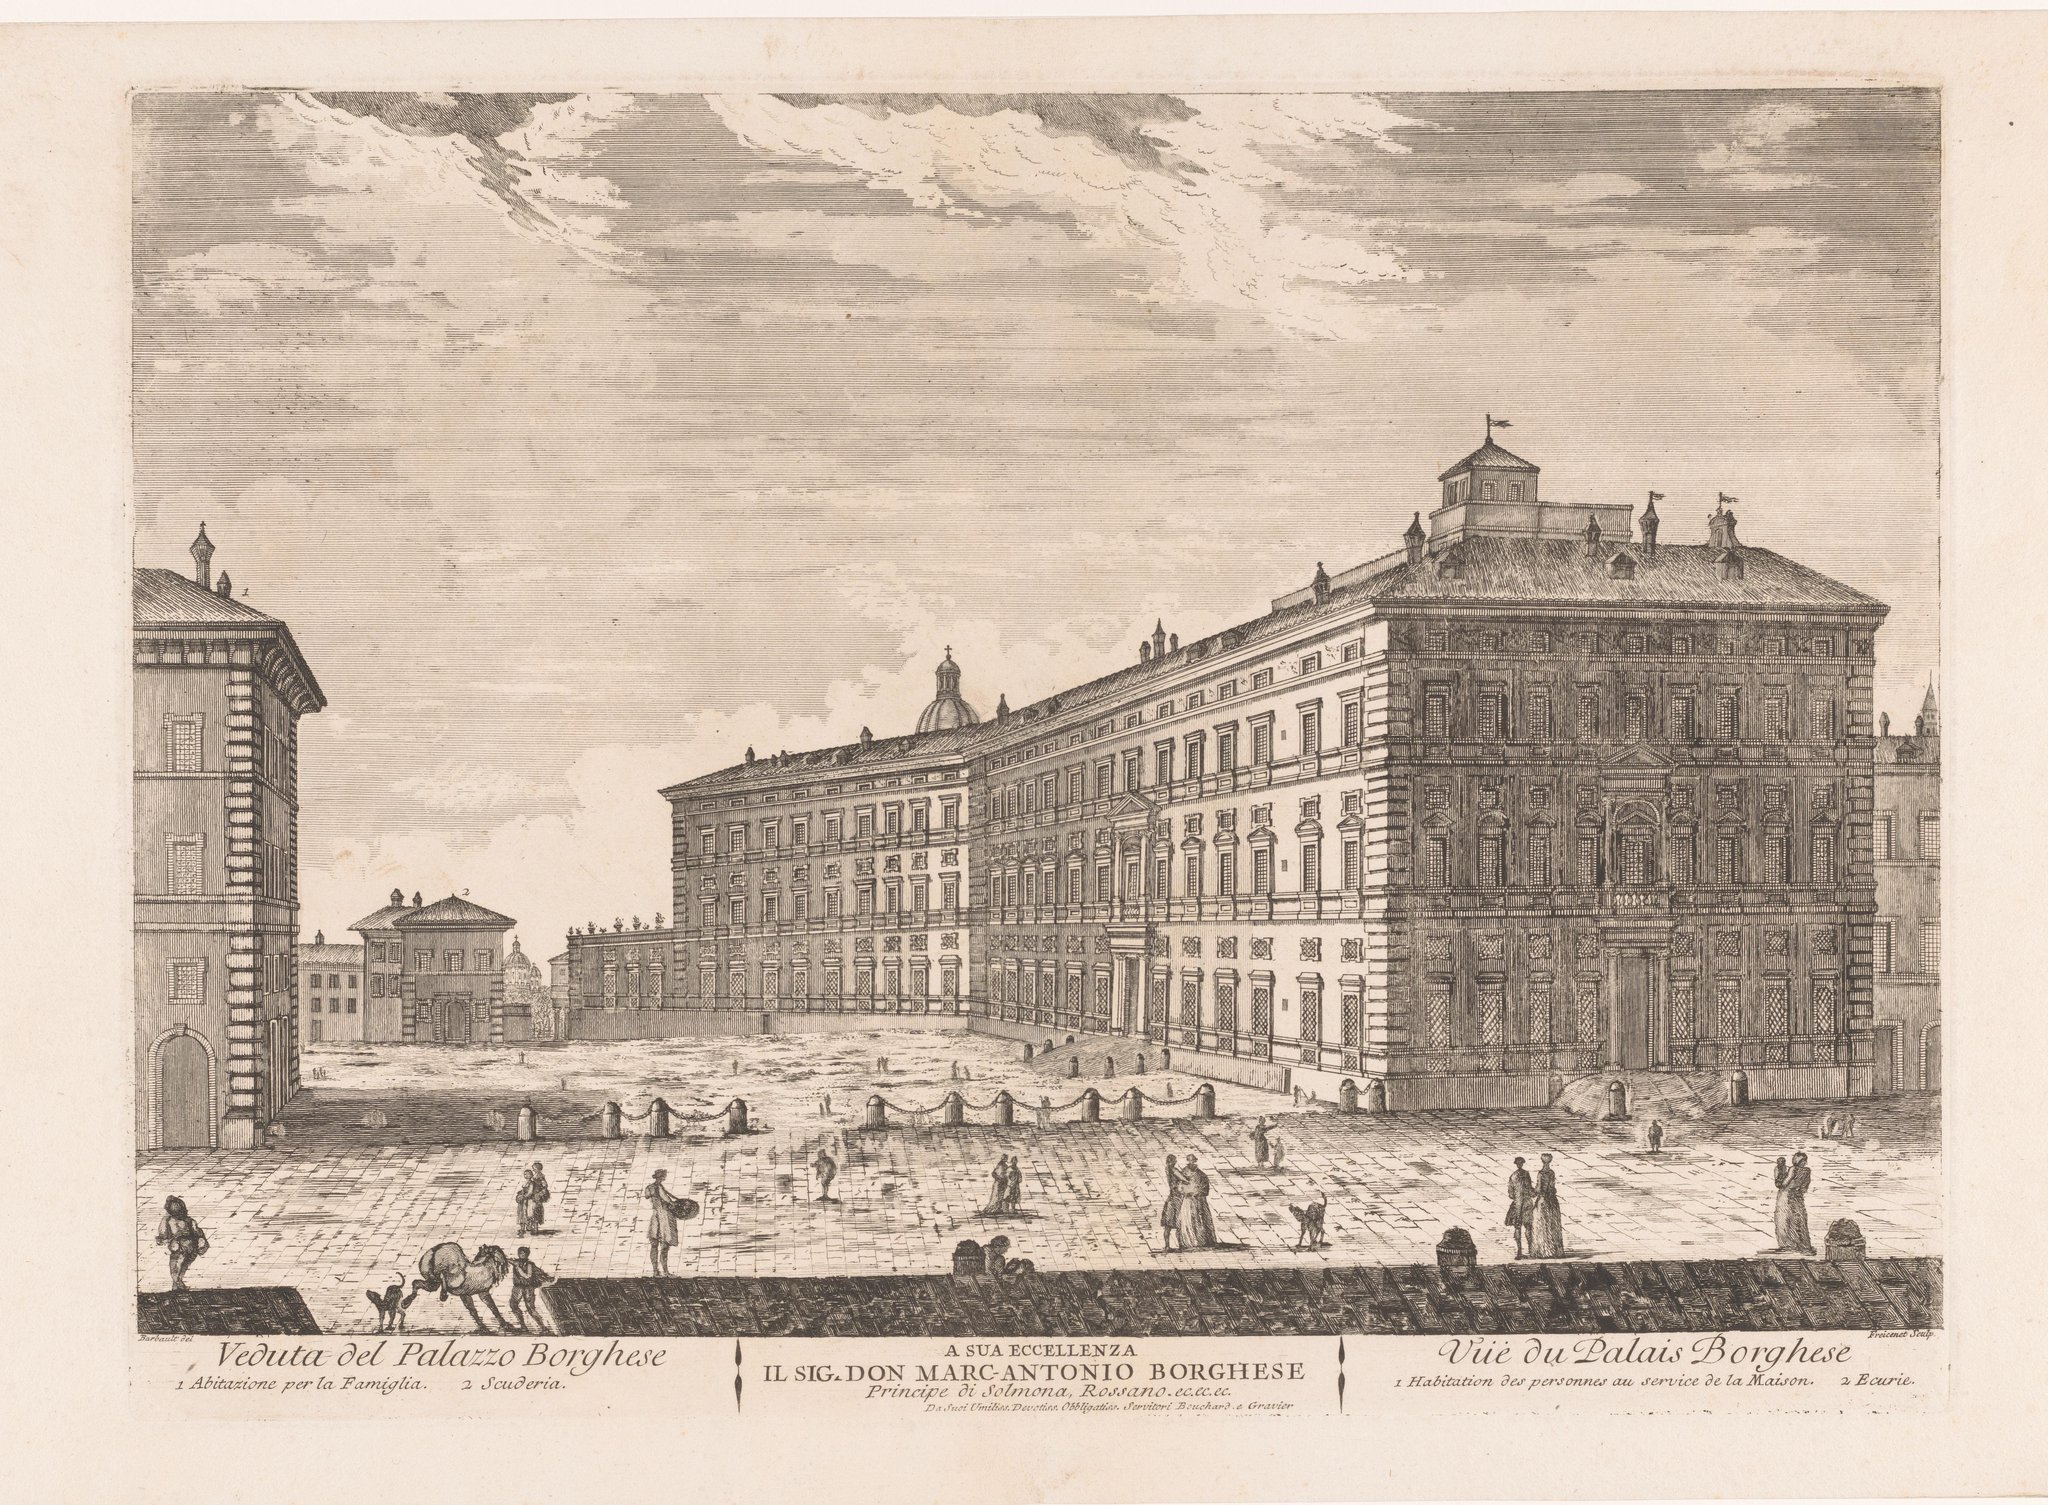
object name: book illustration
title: Gezicht op het Palazzo Borghese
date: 1763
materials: paper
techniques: etching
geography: italy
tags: city-view in general; 'veduta', hôtel, i.e. small palace in city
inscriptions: collector's mark: Lugt 2228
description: Prent gebruikt voor: Barbault, Jean. Les plus beaux édifices de Rome moderne publiés par Jean Barbault peintre (...). Rome: Bouchard et Gravier, 1763.